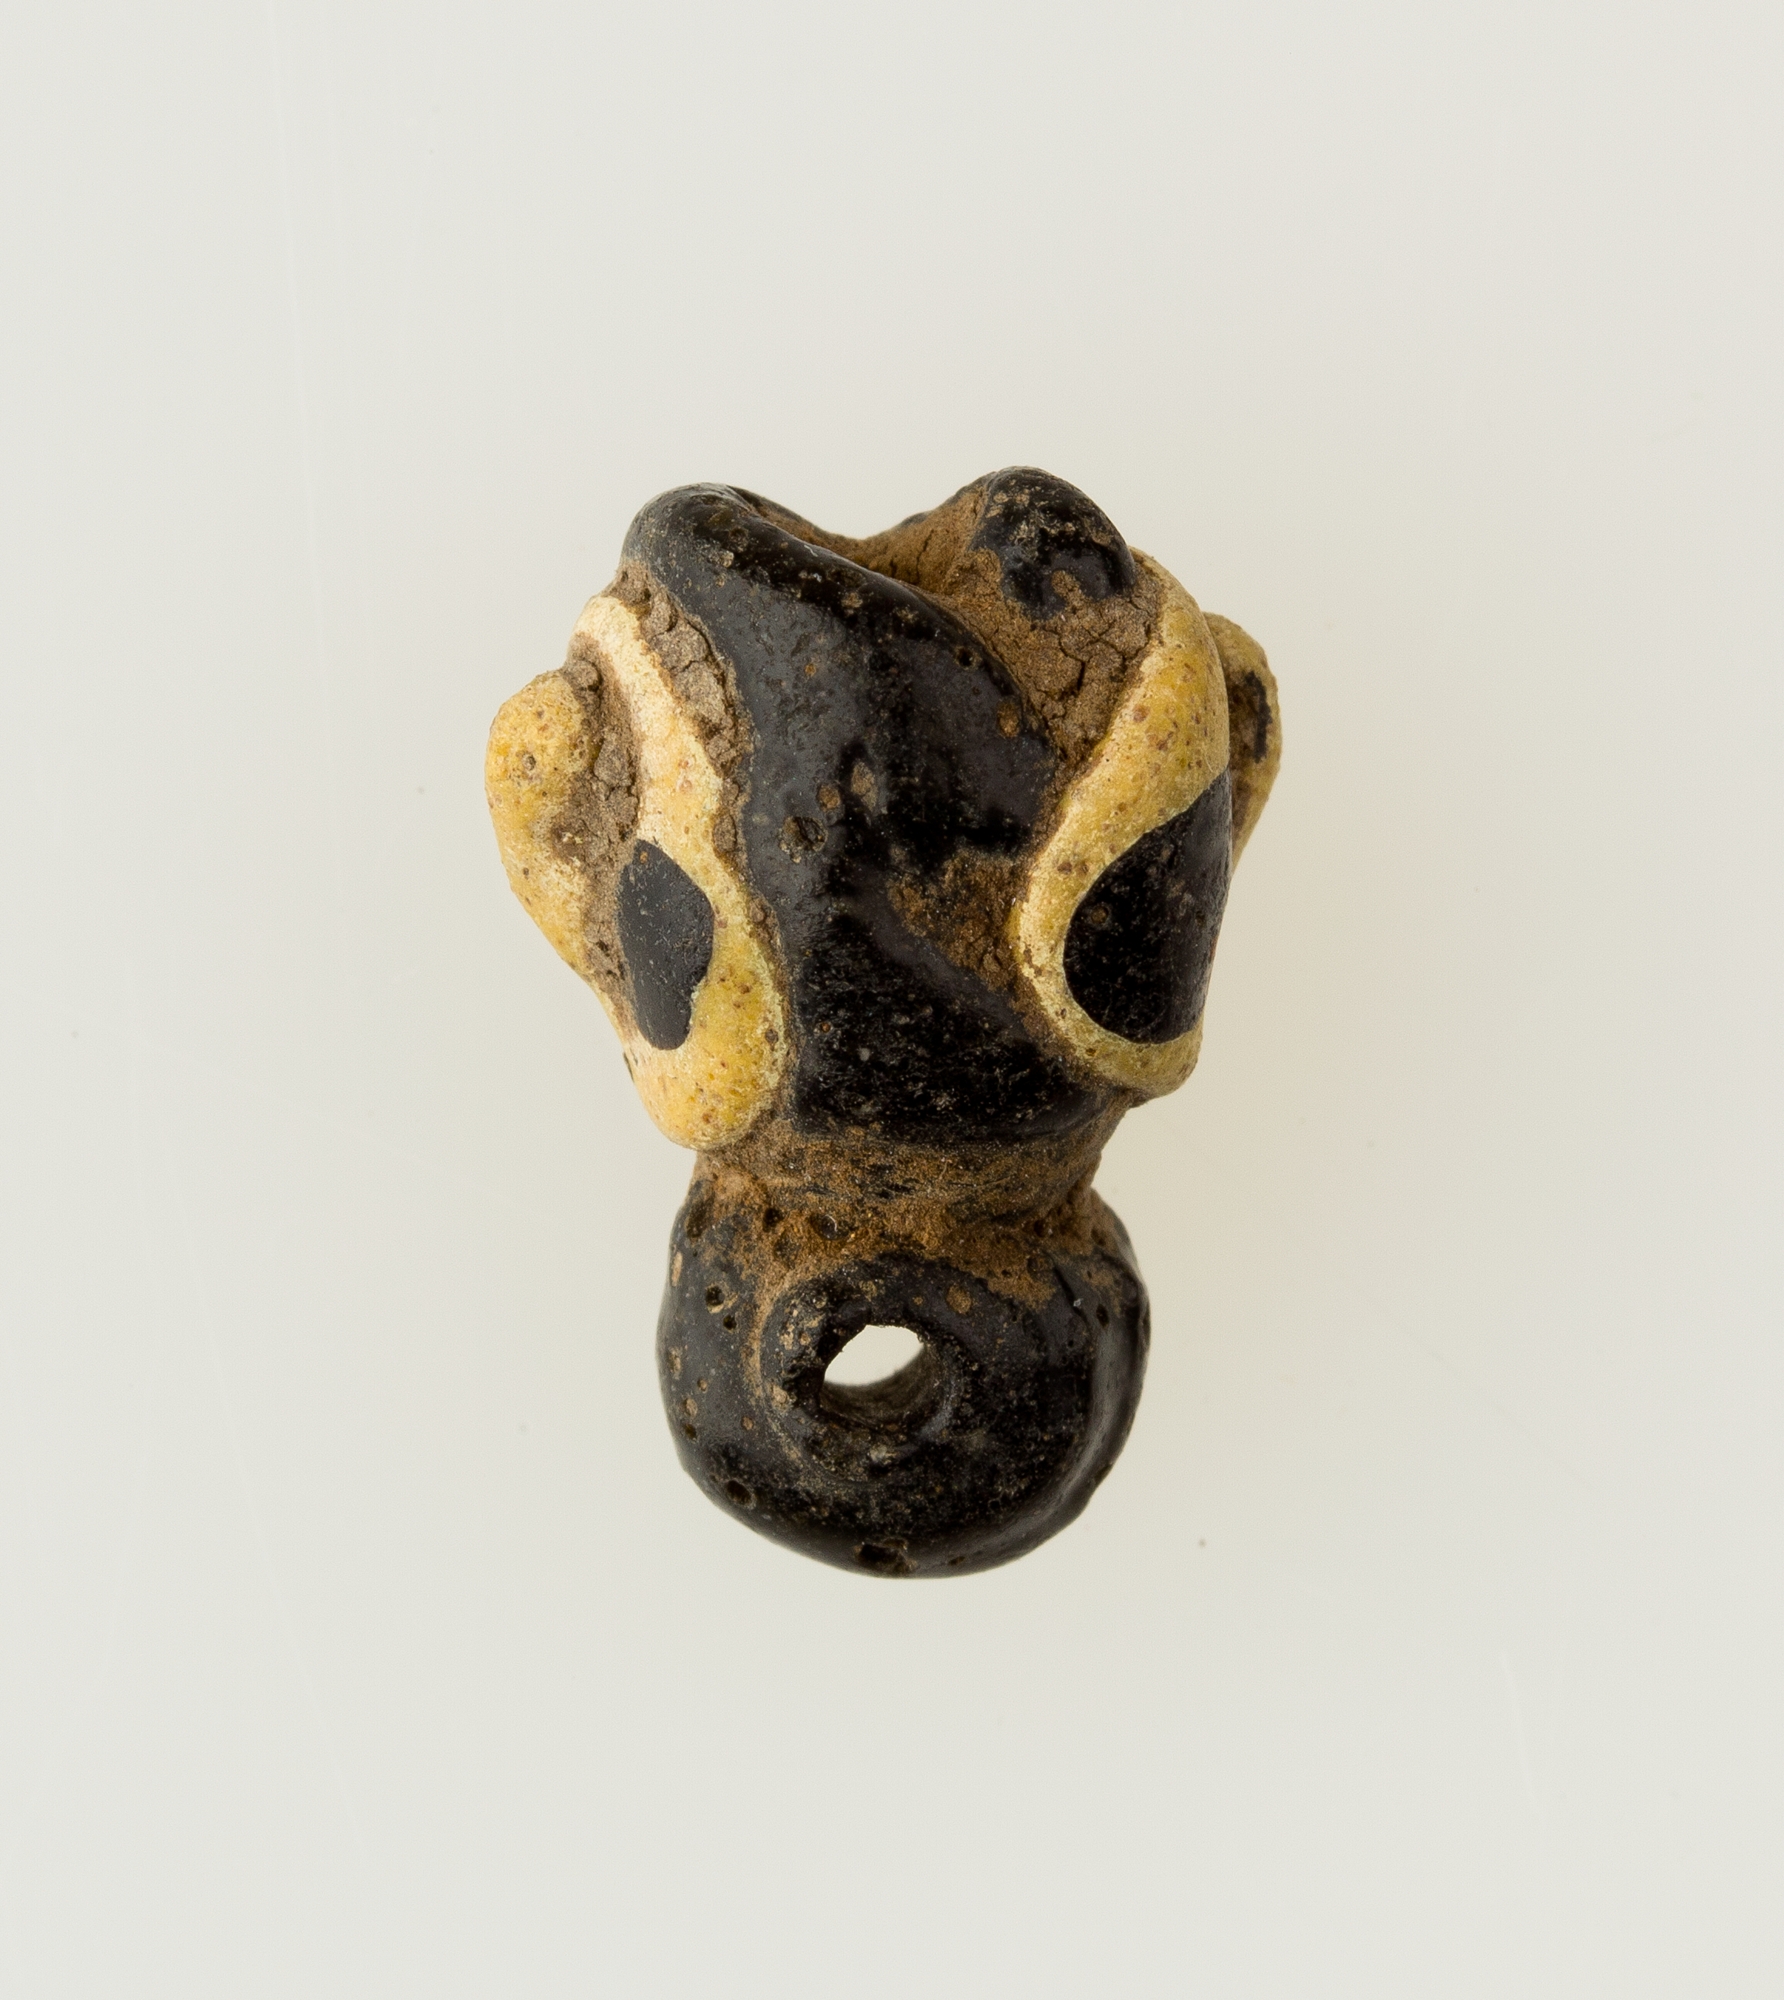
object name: amulet, face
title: Amulet in form of human face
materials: glass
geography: egypt